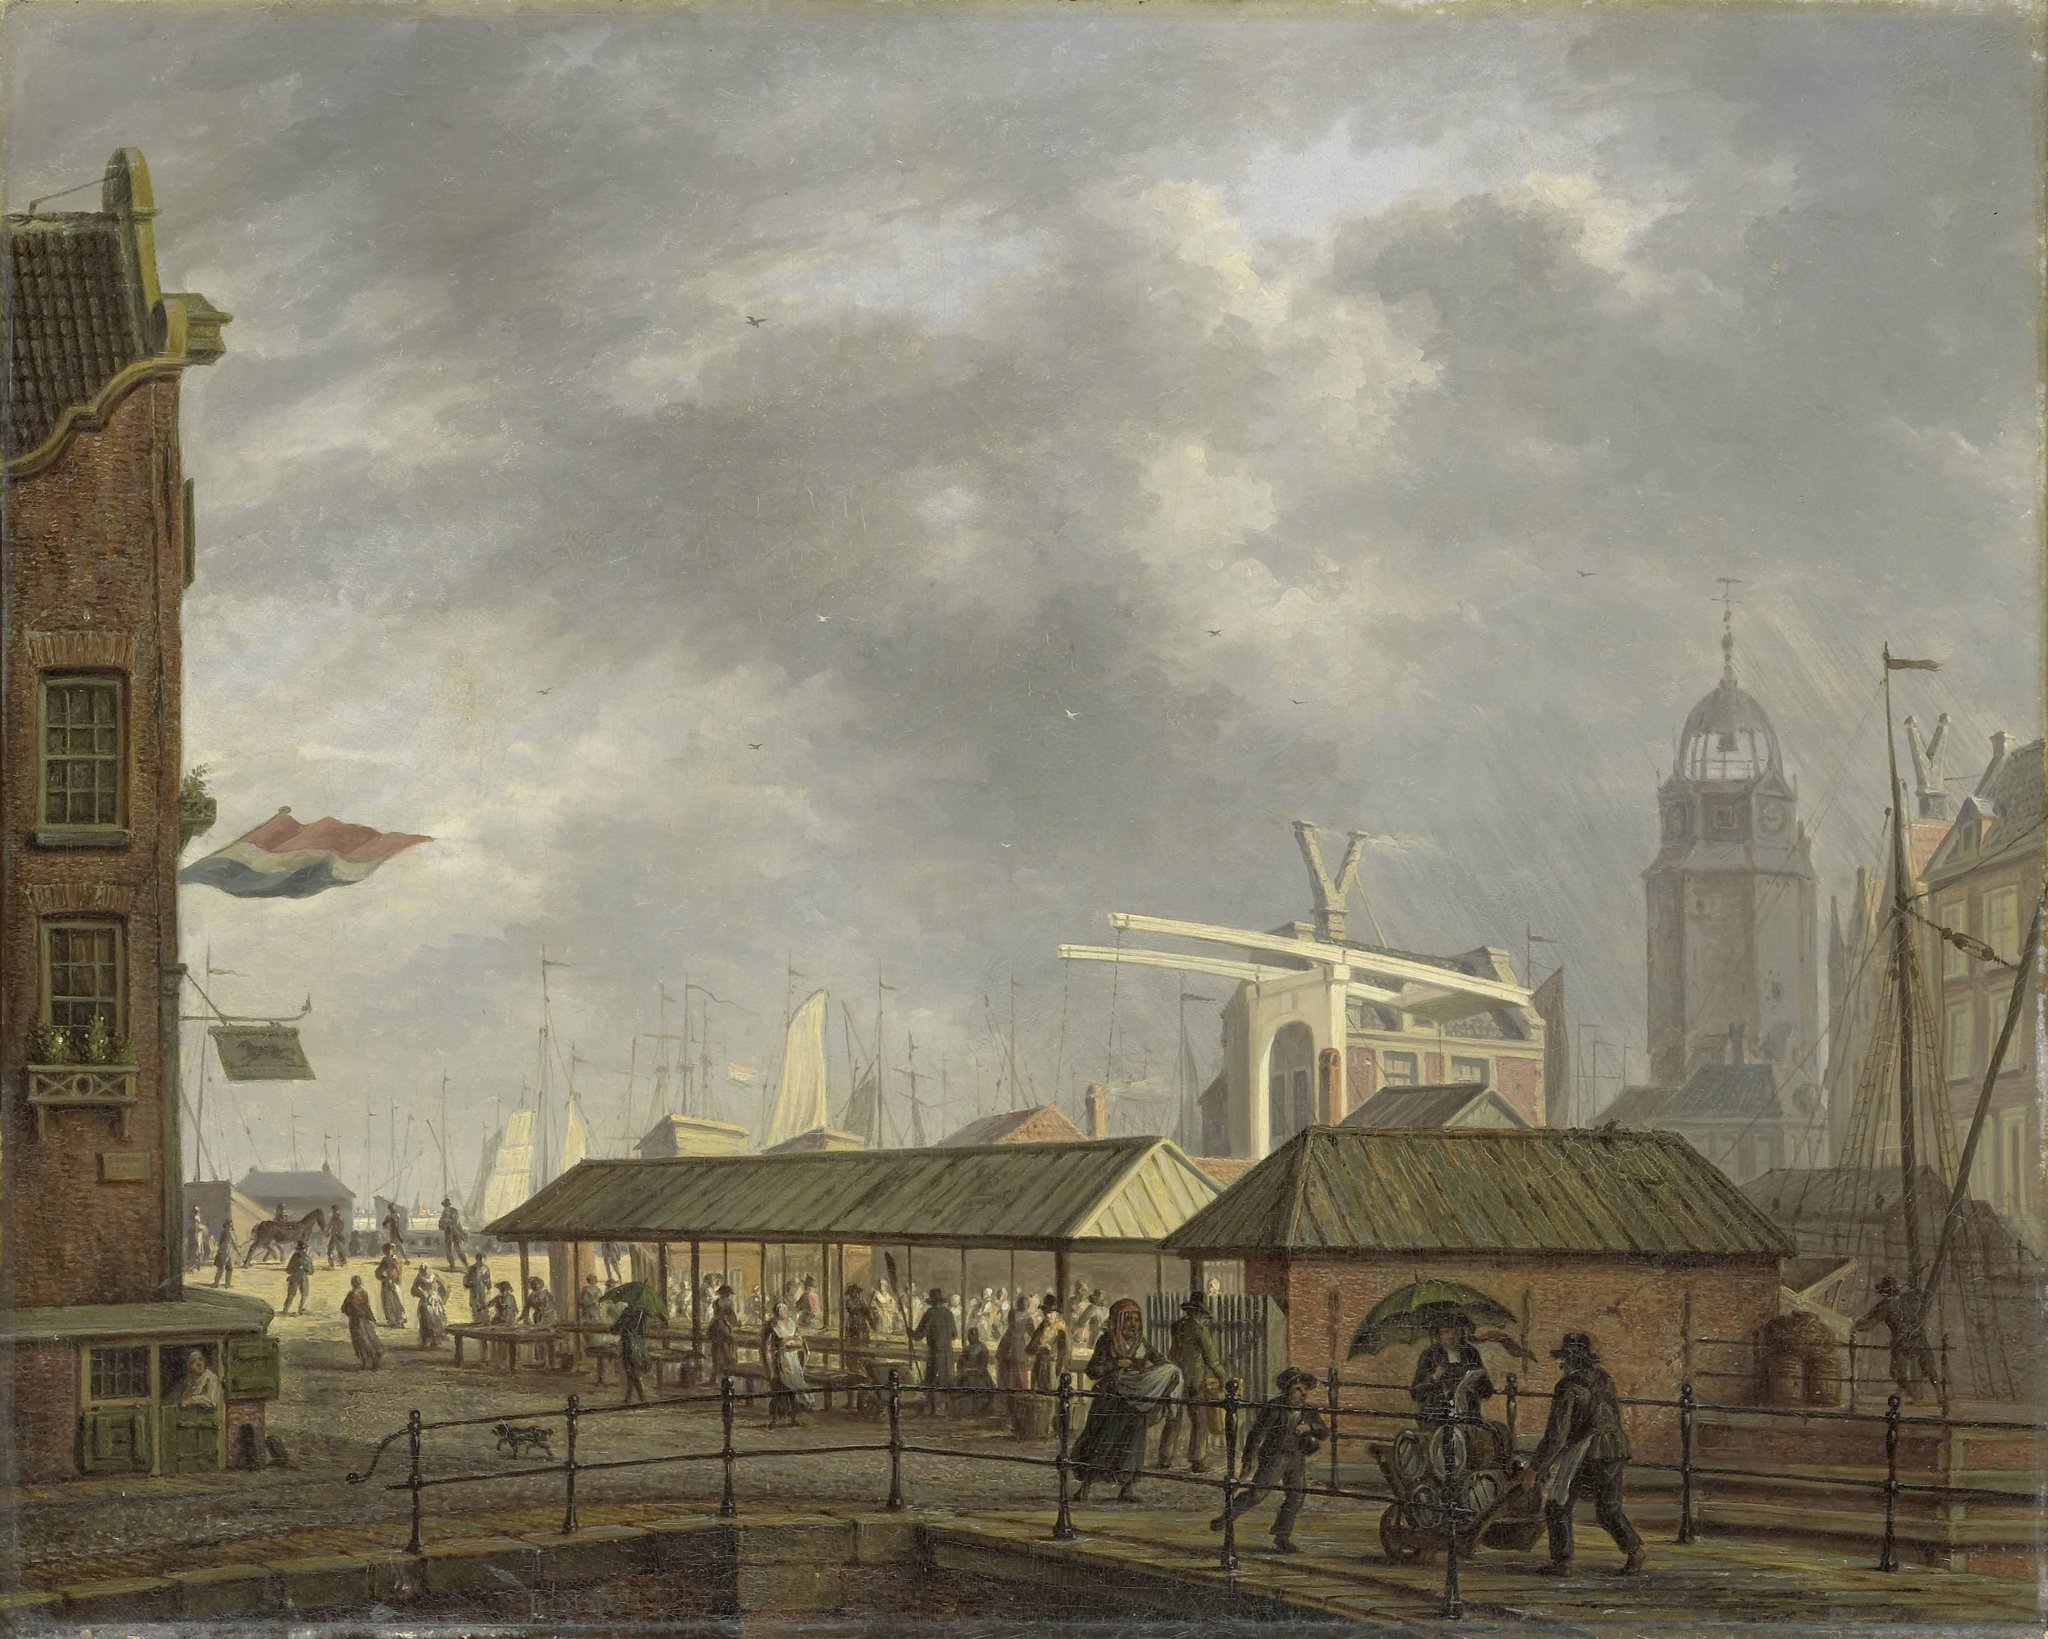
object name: painting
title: The small Fish Market on the Corner of the Brouwersgracht and Singel, Amsterdam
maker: johannes jelgerhuis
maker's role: draughtsman, painter, print maker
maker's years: 1770-1836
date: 1826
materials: canvas, oil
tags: market, amsterdam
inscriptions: signature and date: ‘Jelgerhuis Rzn 1826’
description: Gezicht op de kleine vismarkt op de hoek van de Brouwersgracht en het Singel te Amsterdam op het moment dat een regenbui valt. In het midden de overdekte markt, rechts op de brug een man met een kruiwagen en een man met een paraplu. Op de achtergrond een ophaalbrug, een toren en de masten met zeilen van de schepen in de haven.